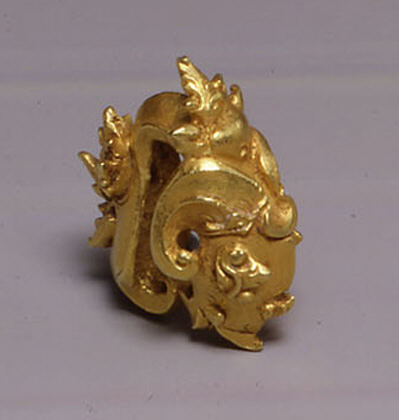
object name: ear ornament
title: Ear Ornament with Ram's Head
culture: indonesian, javanese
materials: gold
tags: rams